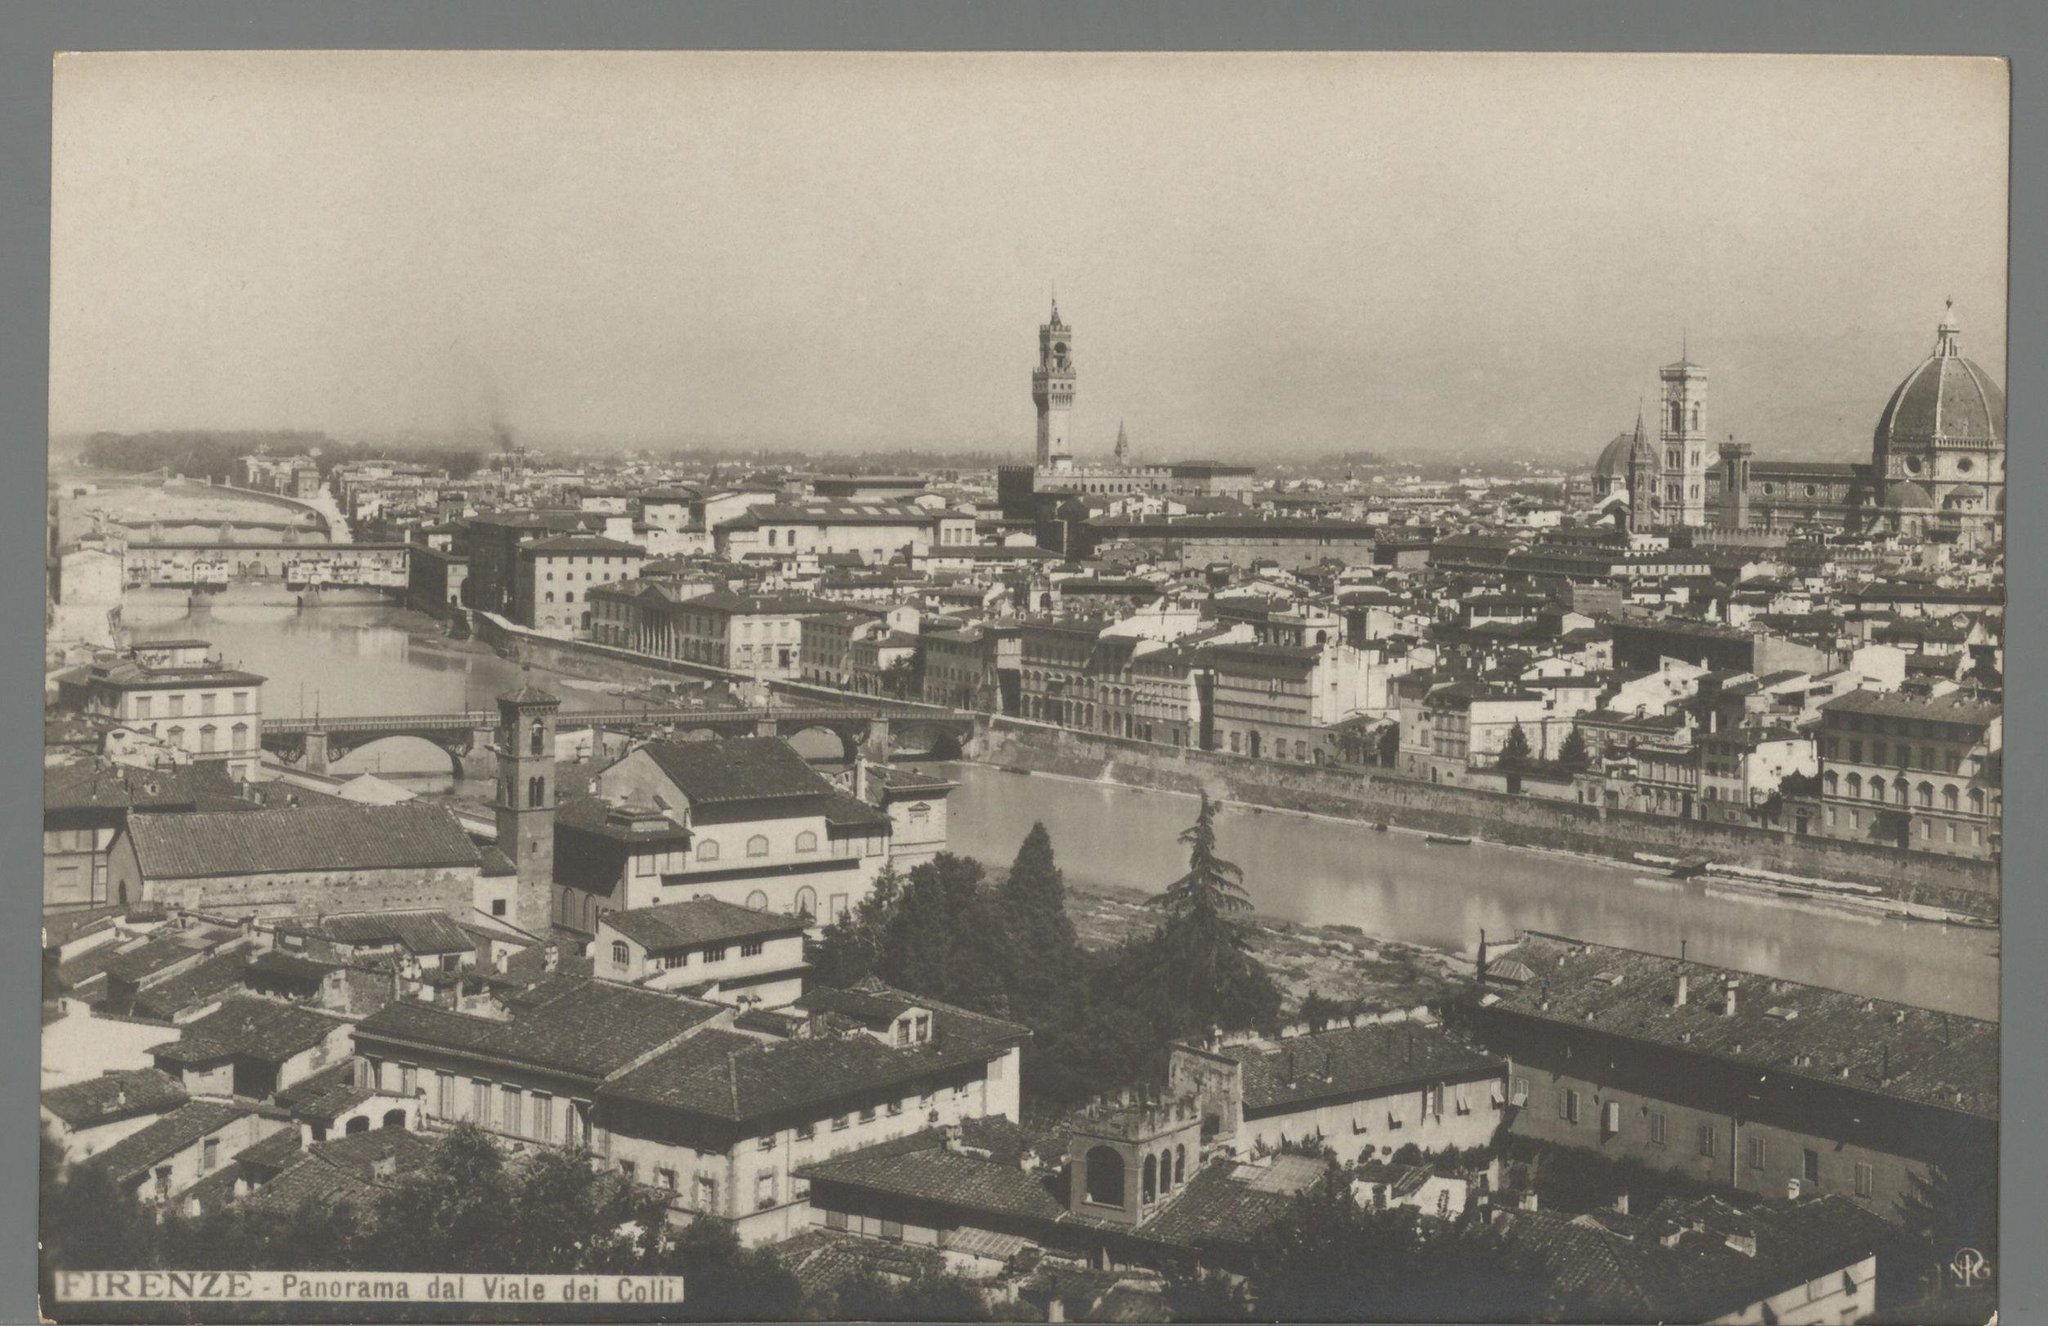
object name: photograph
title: Firenze. Panorama dal Viale dei Colli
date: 1894-1906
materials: paper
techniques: gelatin silver print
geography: milan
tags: church (exterior), inner court of palace or 'hôtel'